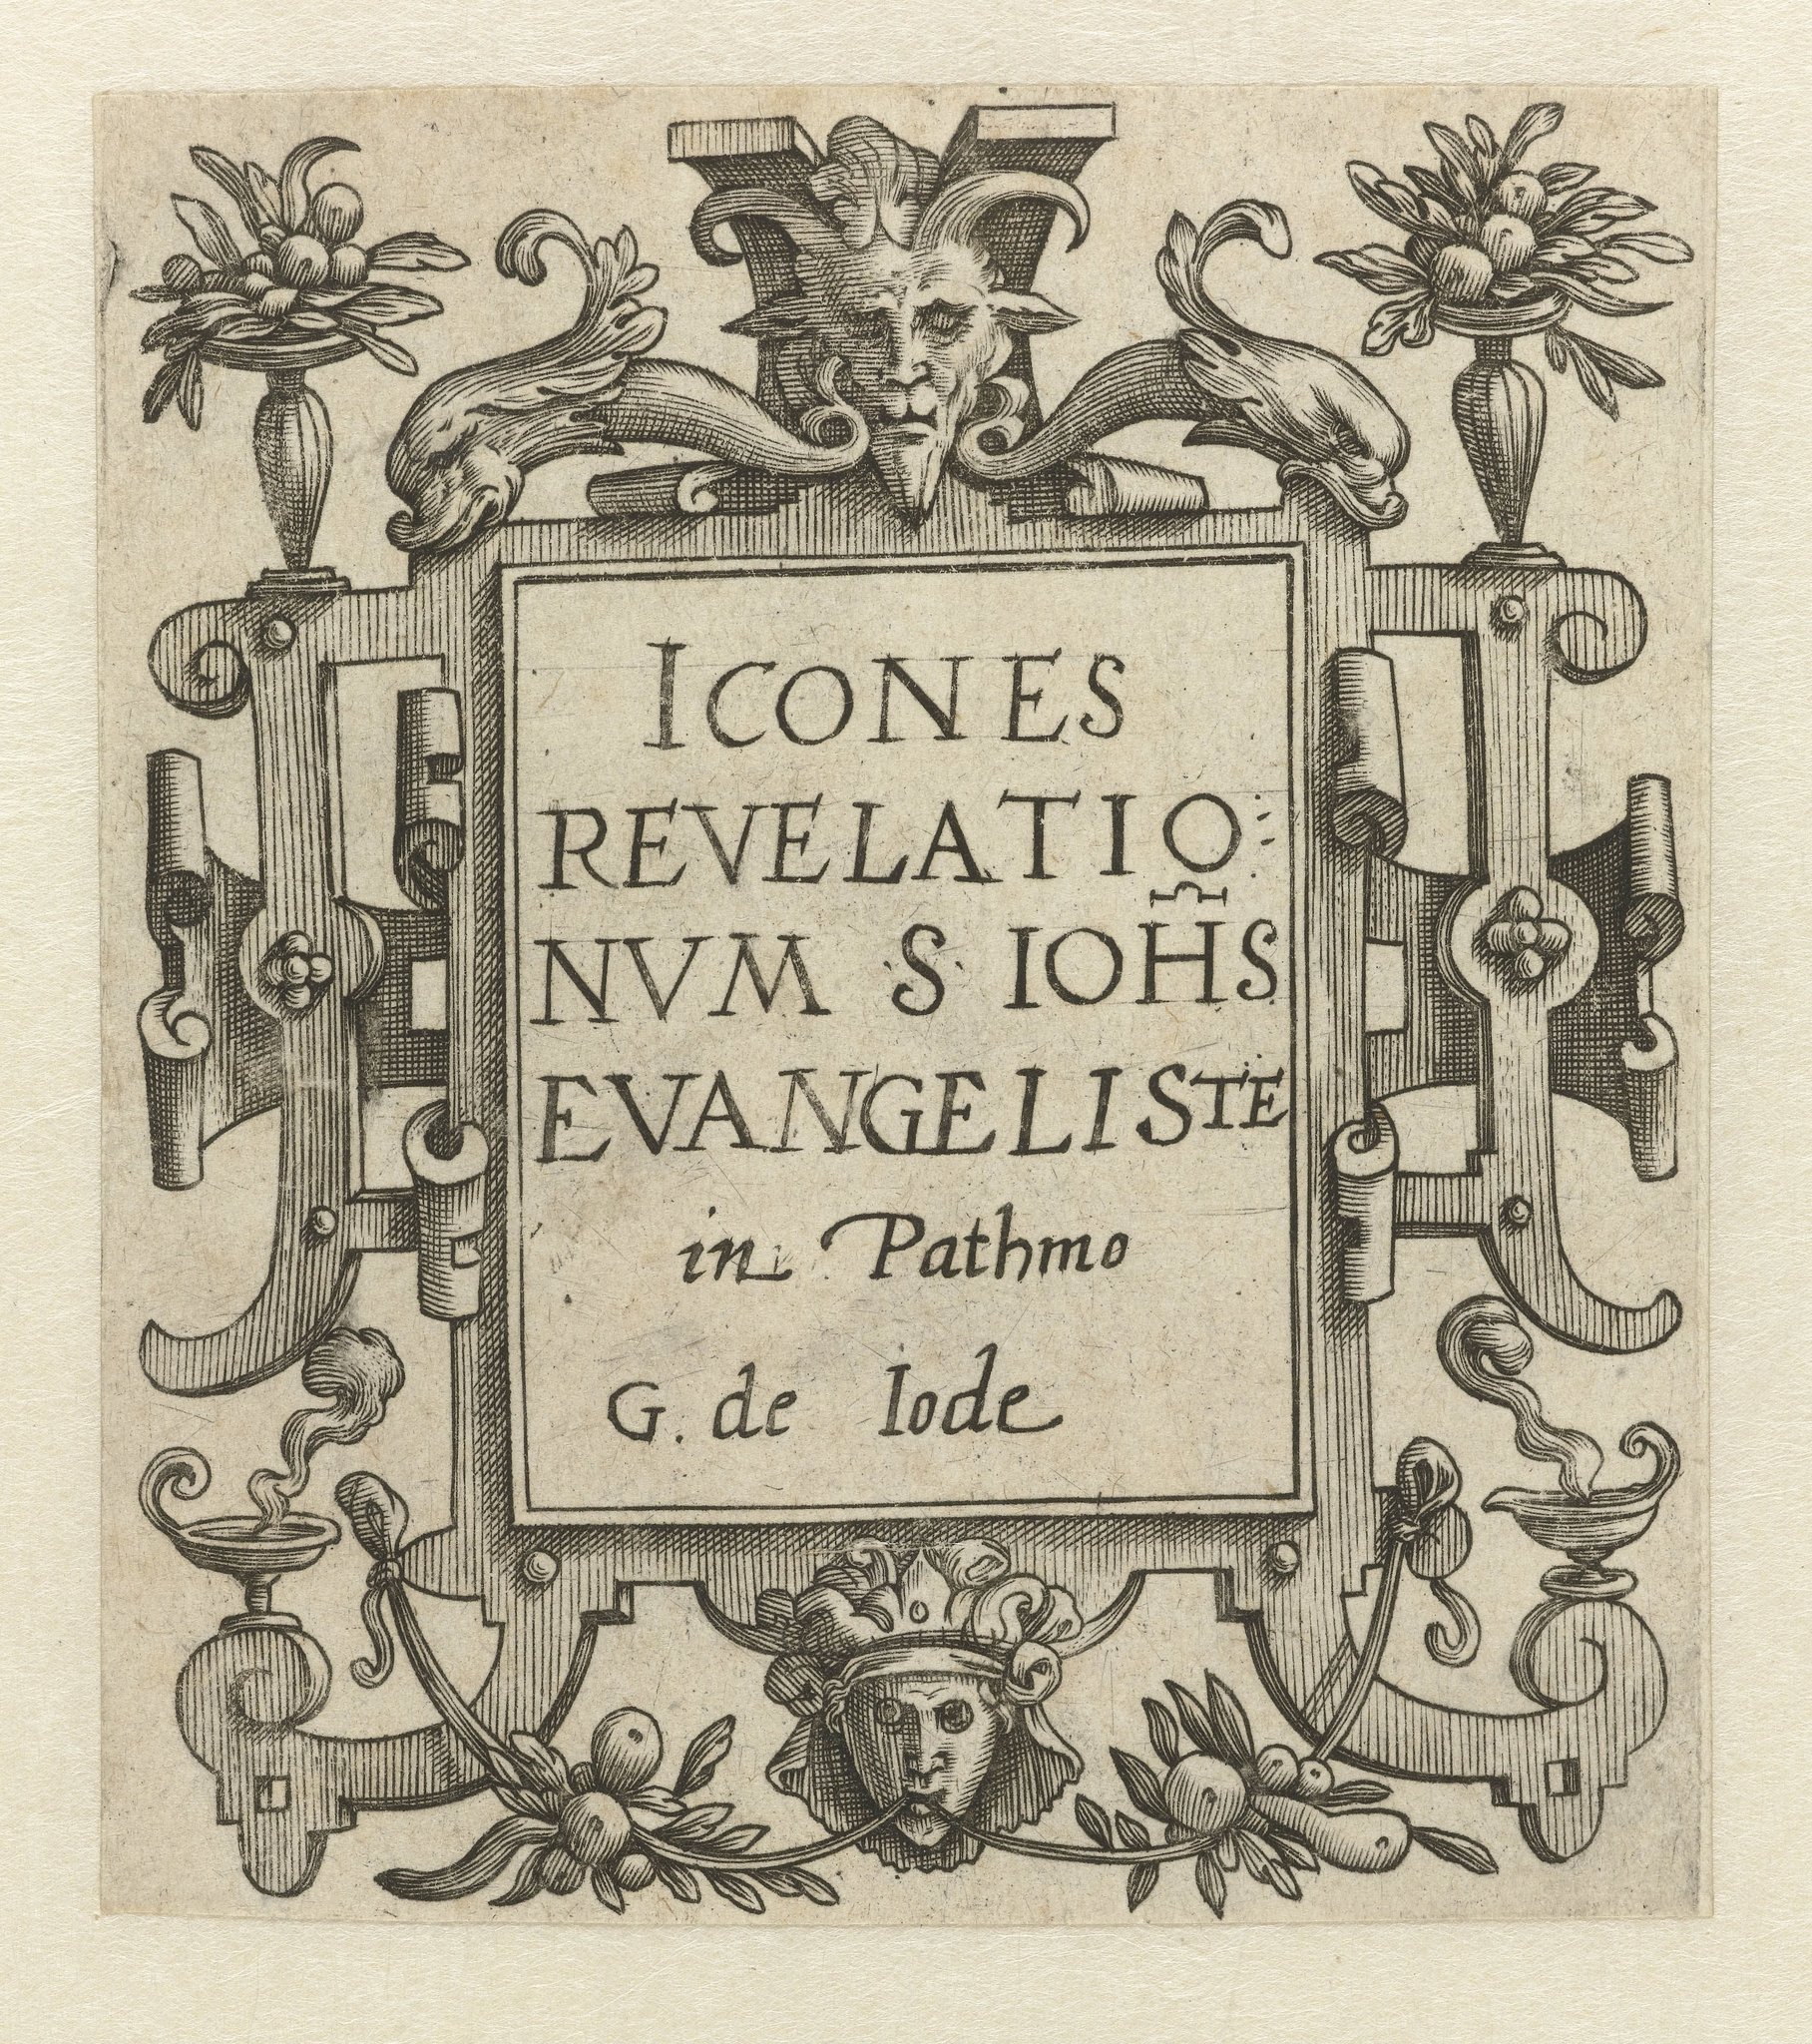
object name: titelprent, frontispice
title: Openbaring van Johannes op Patmos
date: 1585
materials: paper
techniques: engraving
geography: antwerp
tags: the revelation of john, the apocalypse, mask, mascaron ~ ornament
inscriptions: collector's mark: Lugt 2228, collector's mark: Lugt 2760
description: Prent gebruikt in: Thesaurus sacrarum historiaru[m] veteris (et novi) testame[n]ti, elega[n]tissimis imaginibus expressu[m] excelle[n]tissimoru[m] in hac arte viroru[m] opera : nu[n]c primu[m] in luce[m] editus. Antwerpen: Gerard de Jode, 1585.